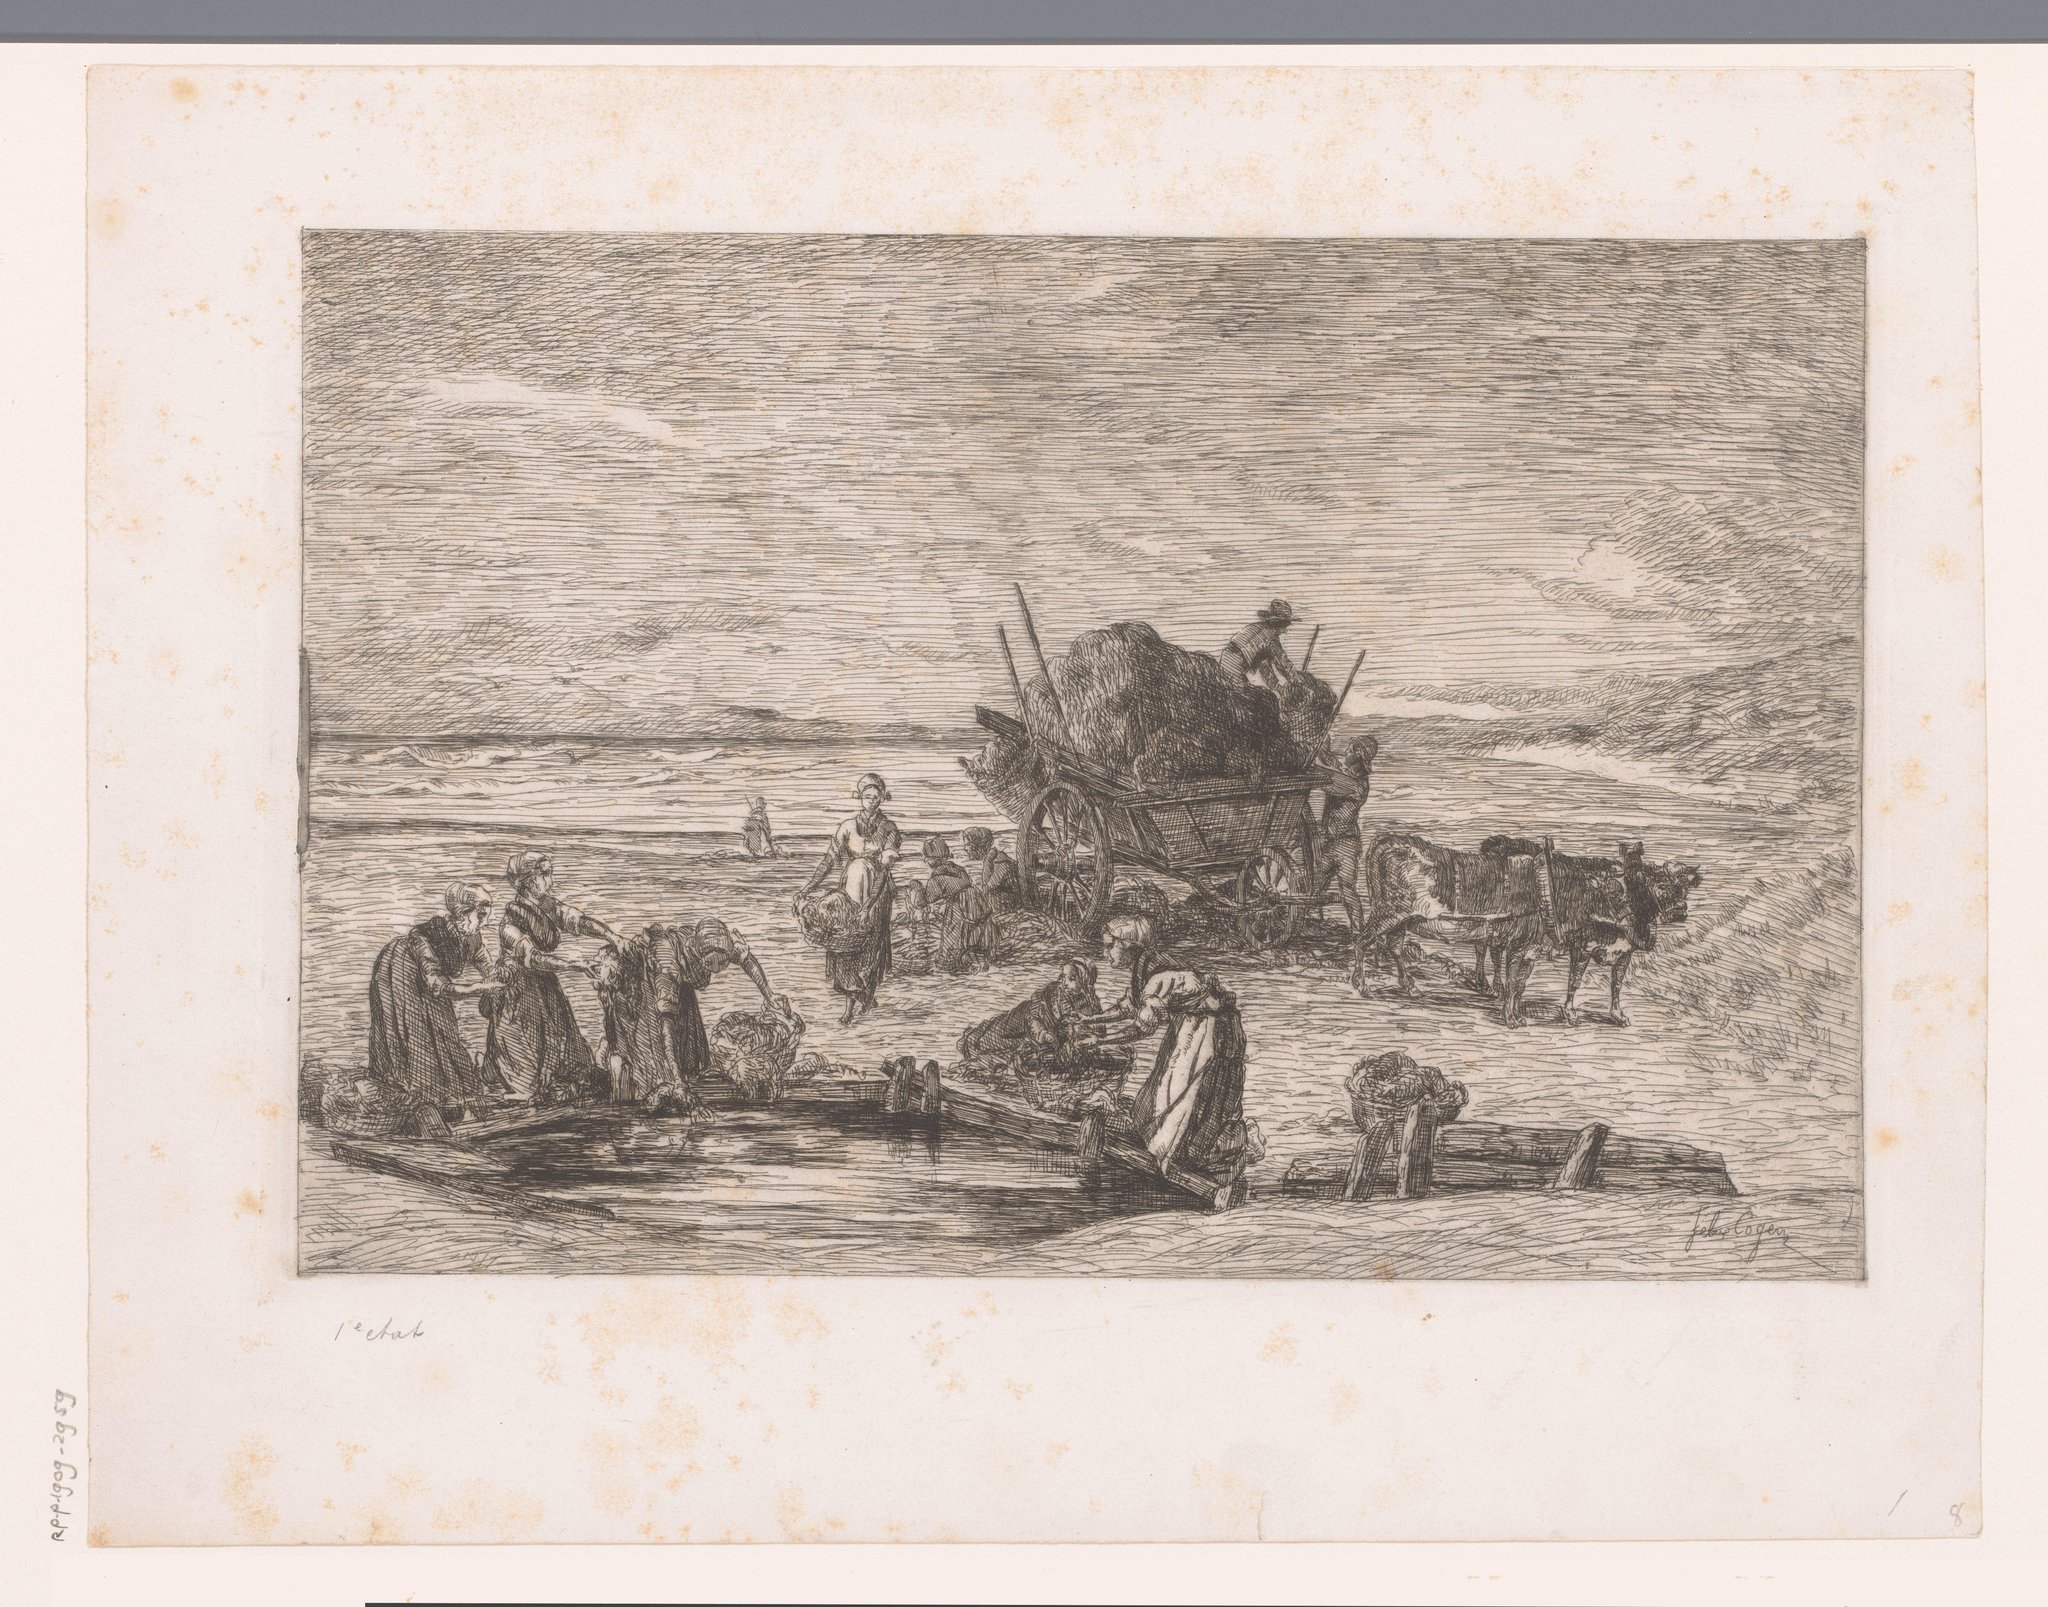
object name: print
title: Mensen verzamelen zeewier aan de duinkust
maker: félix cogen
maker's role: print maker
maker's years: 1838-1907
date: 1875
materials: paper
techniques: etching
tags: dune coast, cow, three-wheeled, animal drawn vehicle, algae, seaweed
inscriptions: collector's mark